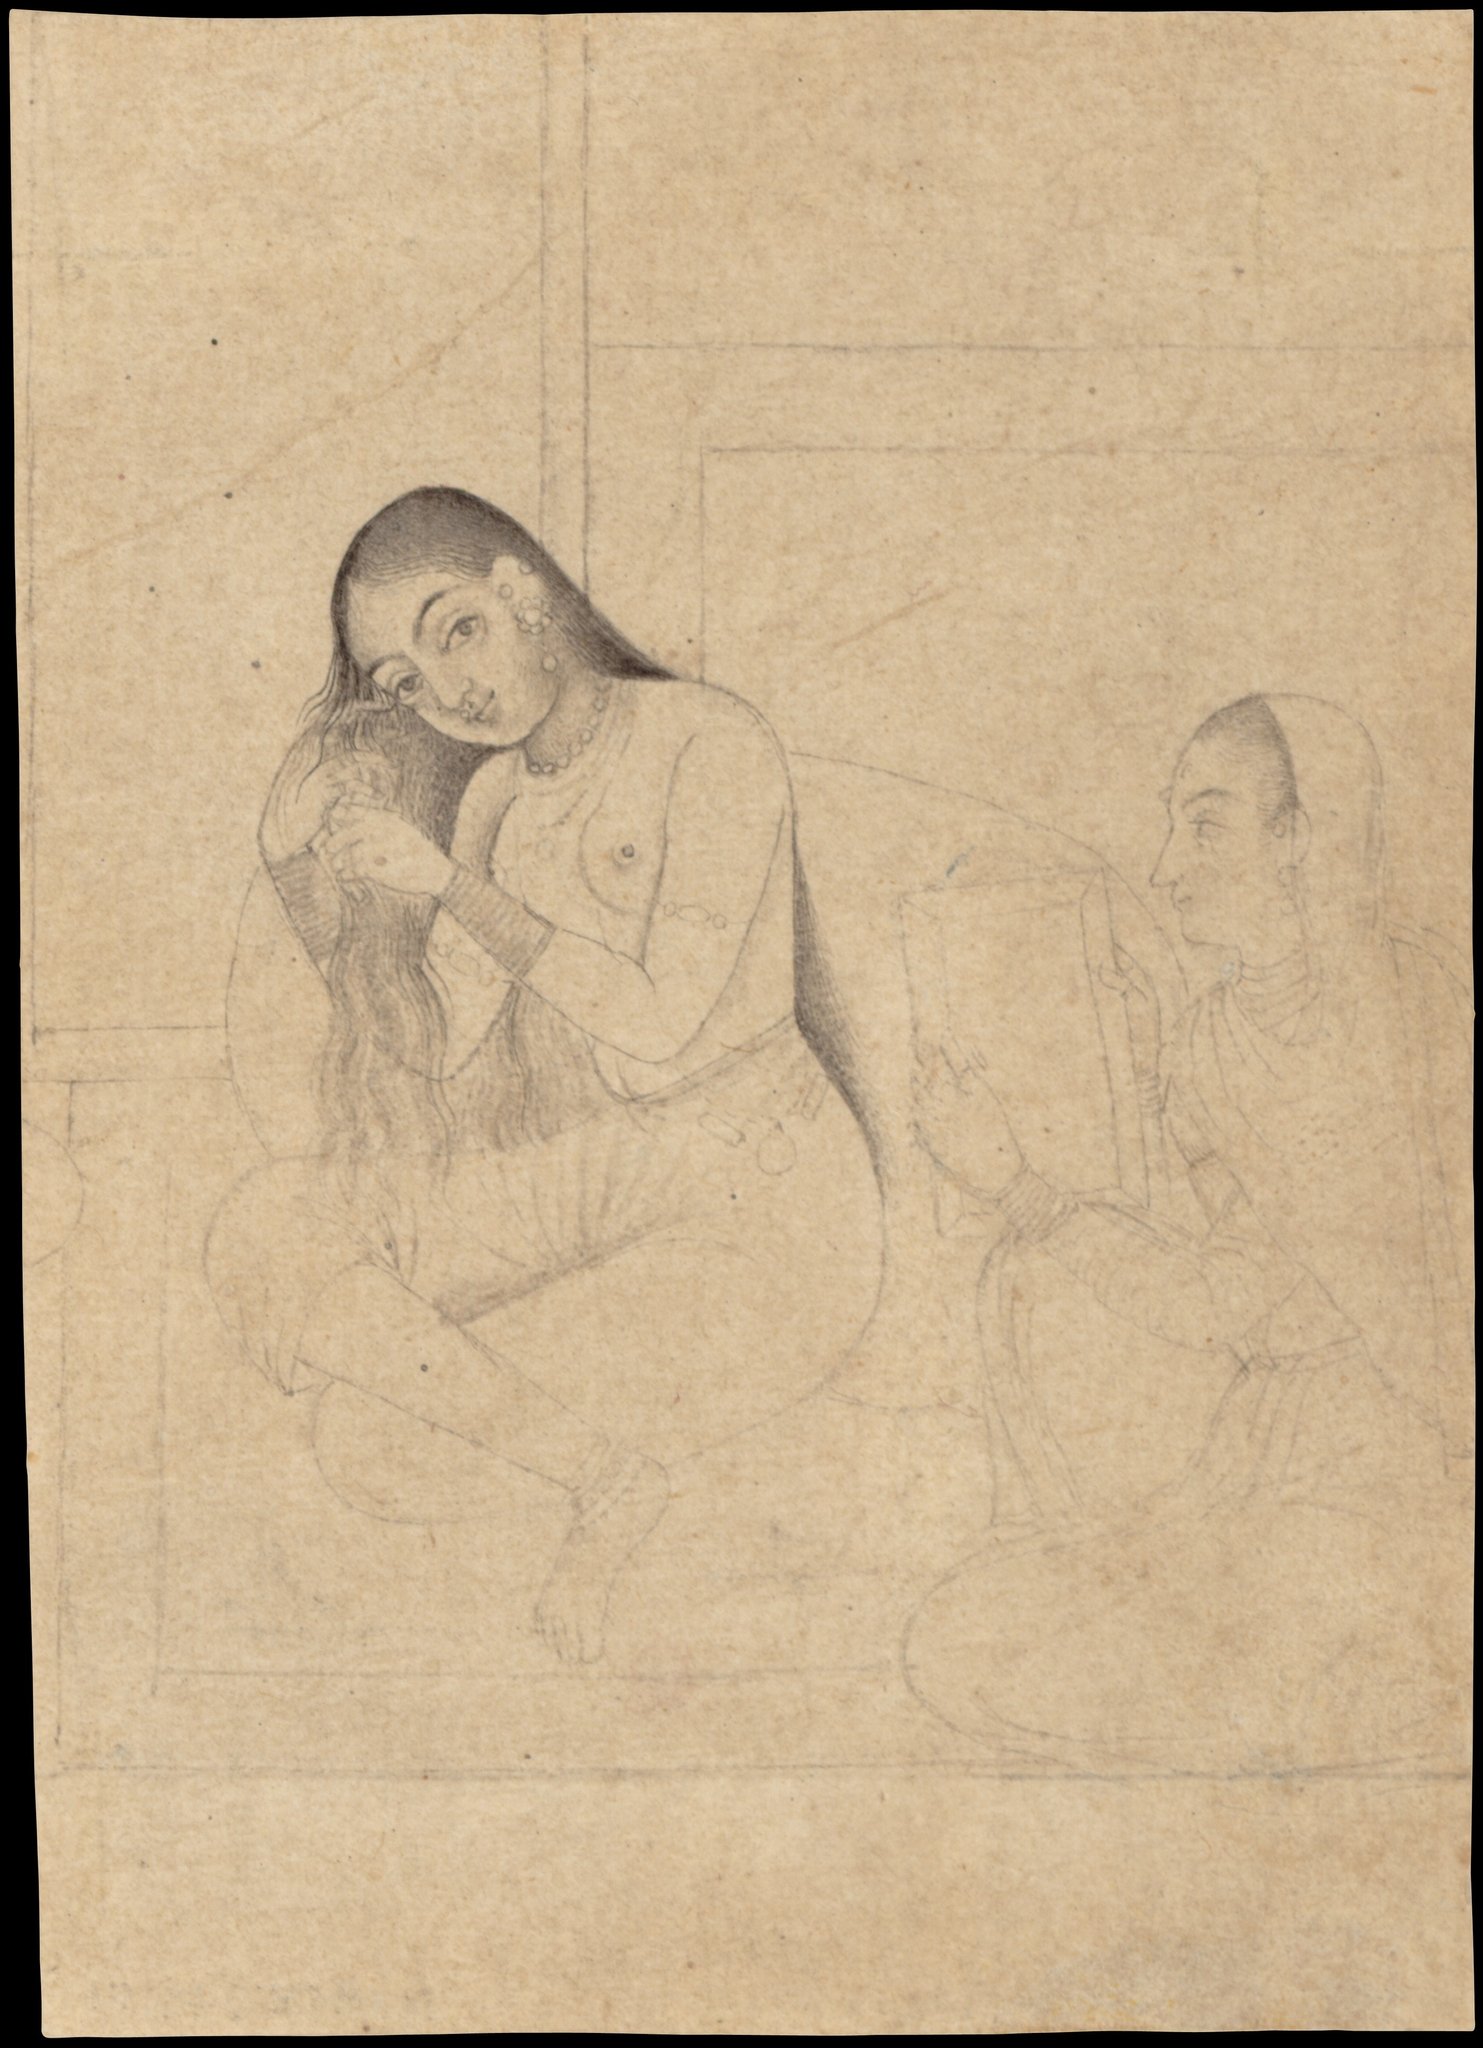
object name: illustrated single work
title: Lady at her Toilette with a Servant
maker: haydar ahmad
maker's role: artist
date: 1701-1800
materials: paper, pencil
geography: india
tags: women,female nudes,servants